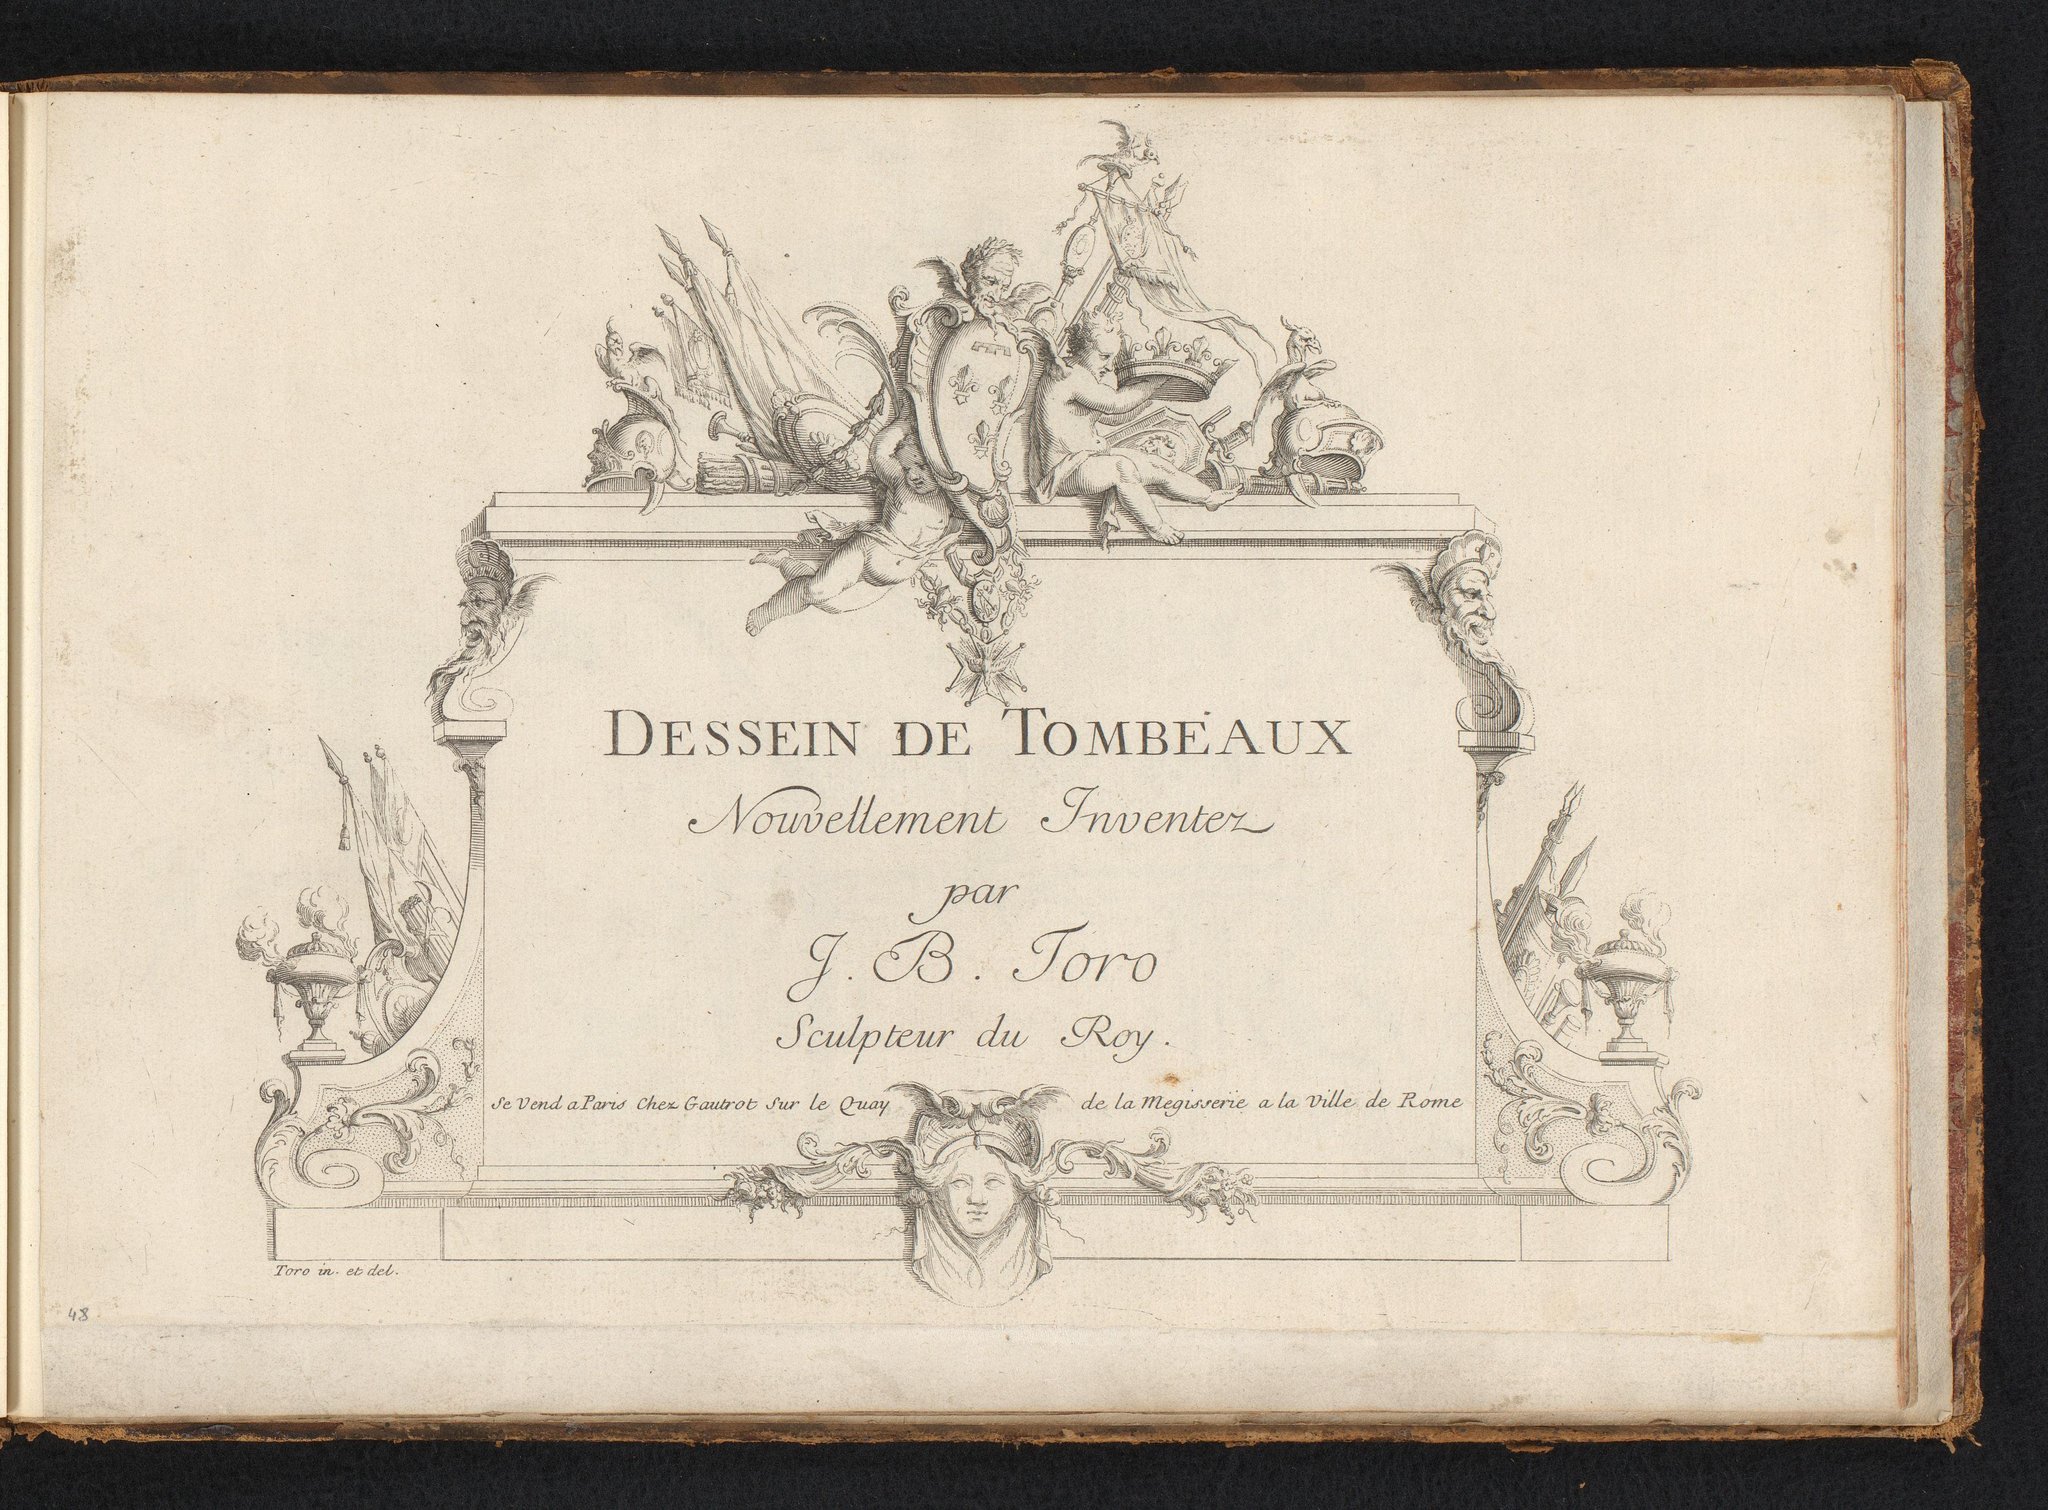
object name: titelprent, frontispice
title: Titelprent met tombe en oorlogstrofeeën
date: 1682-1739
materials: paper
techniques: etching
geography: paris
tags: 'tropaion', i.e. decorative ornament ~ weapons, grave, tomb, armorial bearing, heraldry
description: Bovenop de tombe zitten twee putti die een kroon en het wapen van het hertogdom Orléans omhooghouden. Prent maakt deel uit van een album.